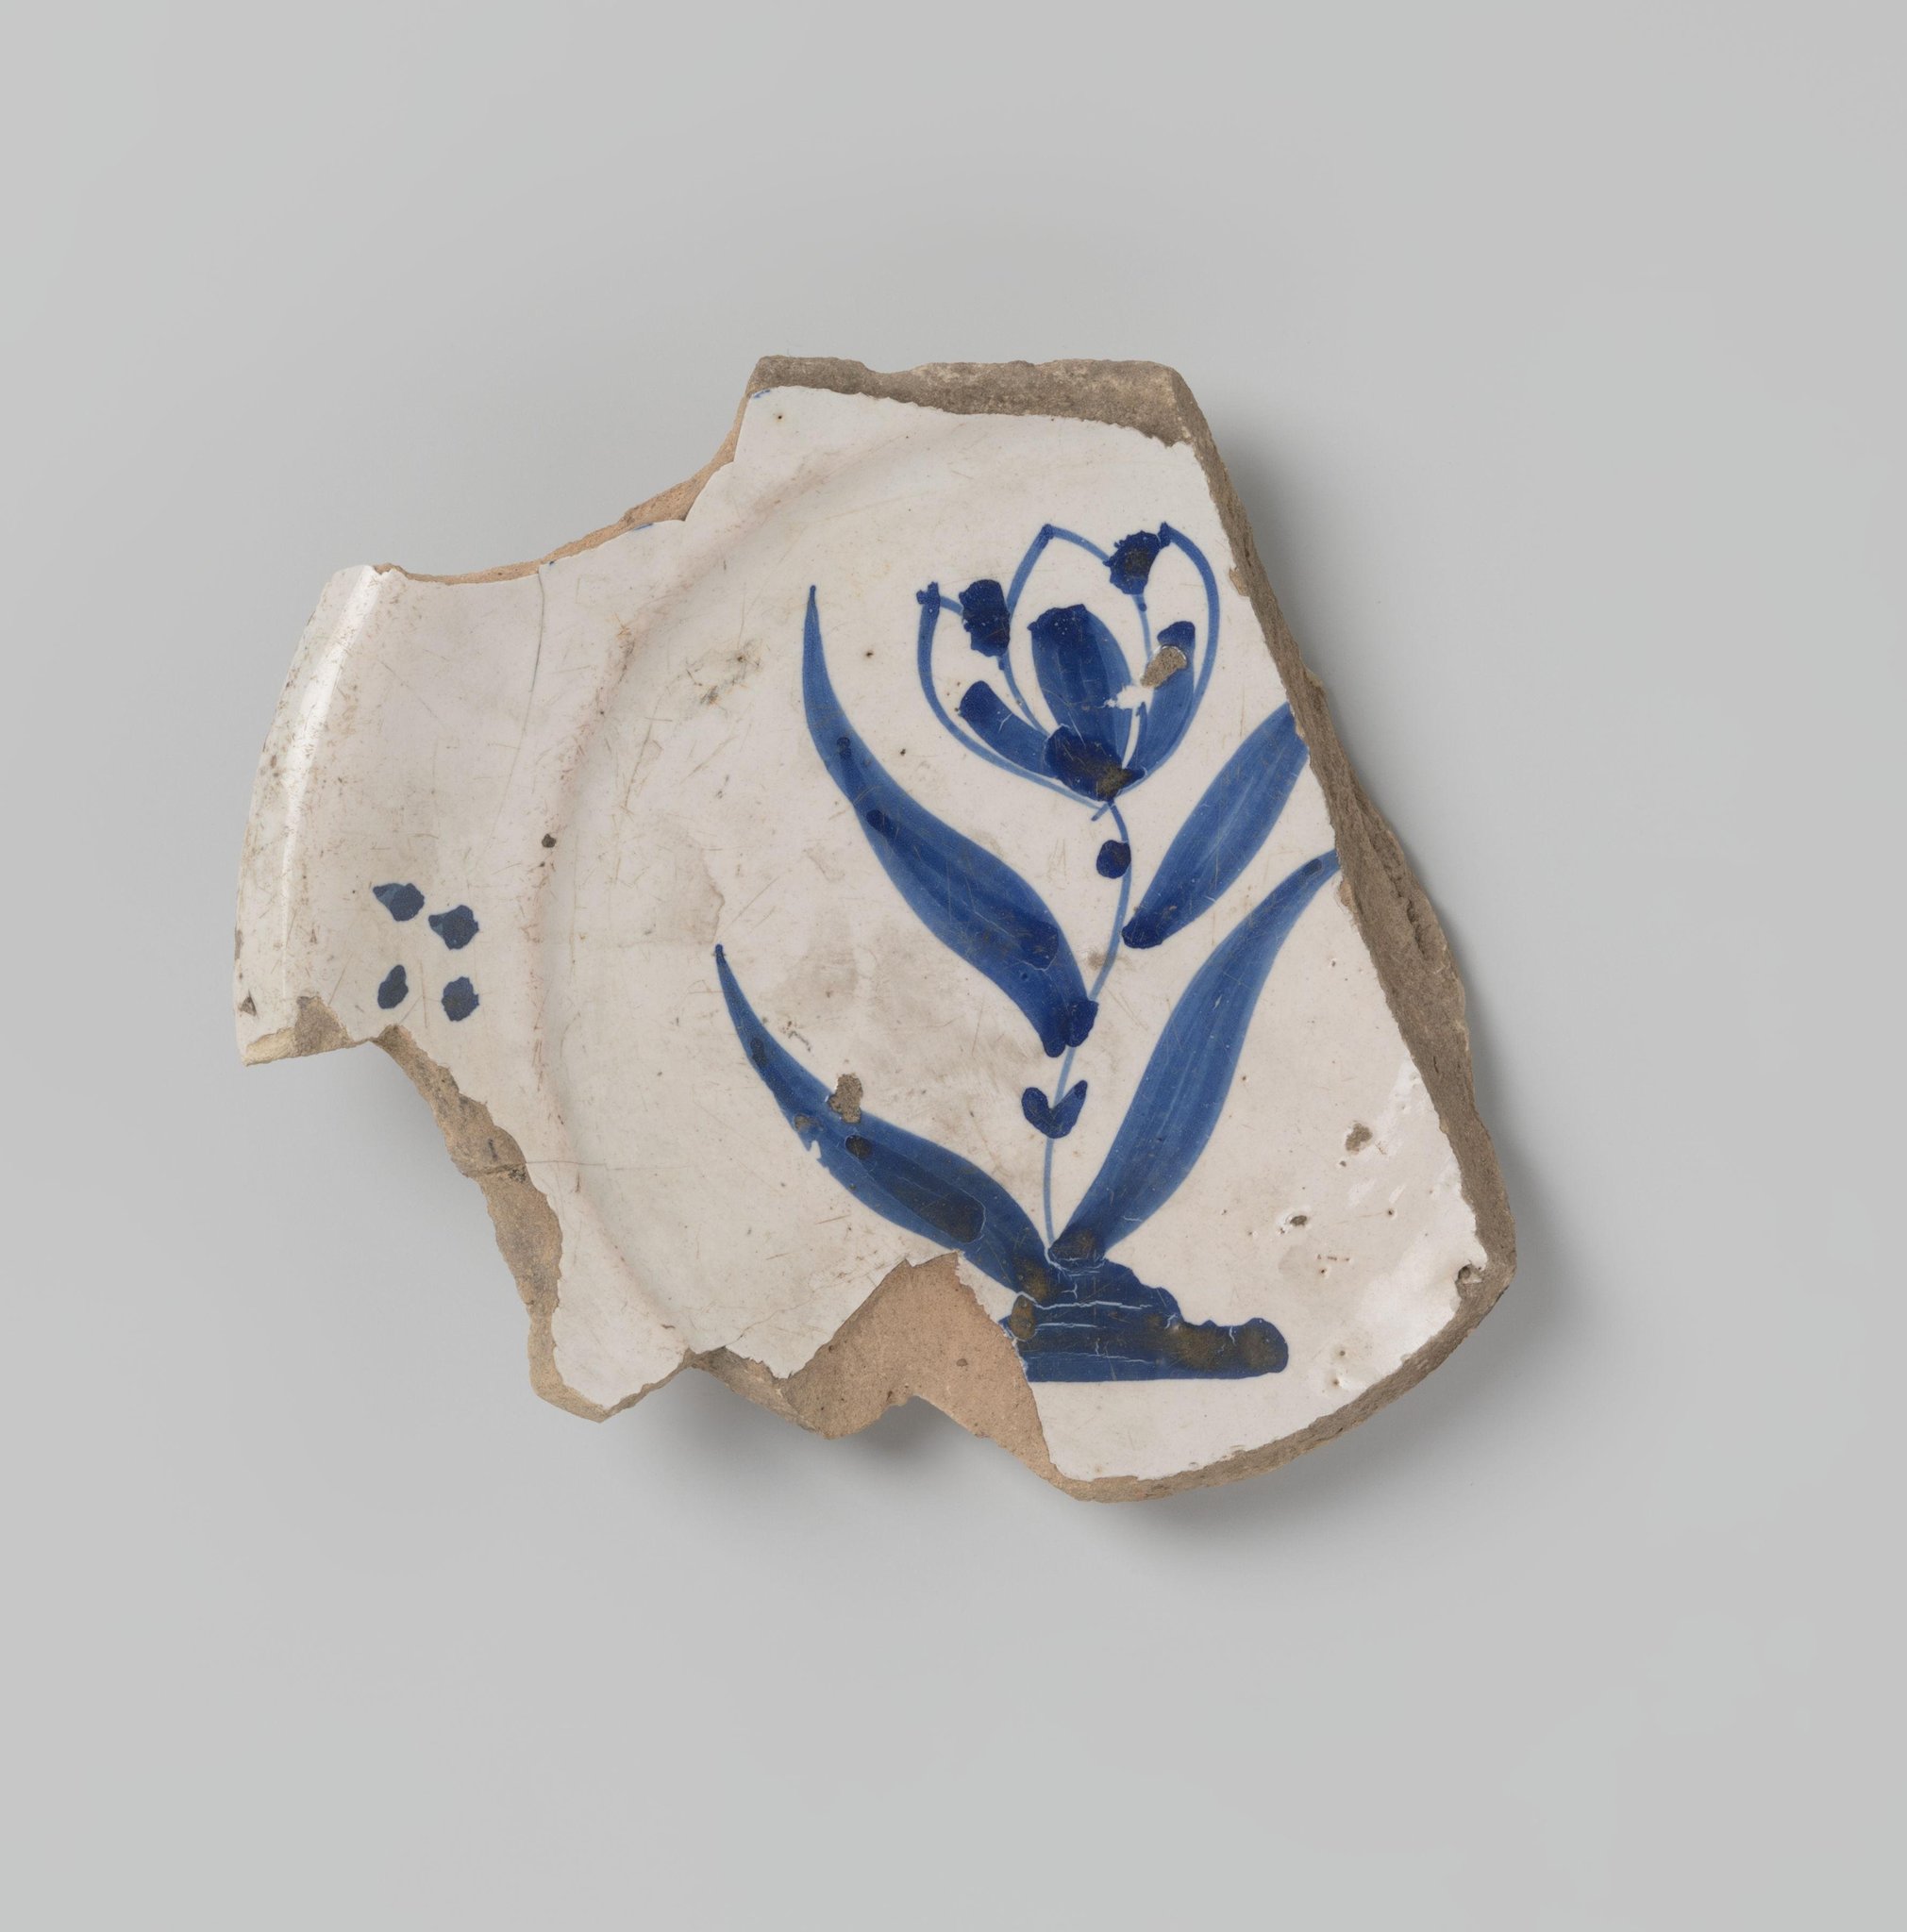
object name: sherd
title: Schotelscherf van aardewerk met tekening een tulp, in onderglazuur blauw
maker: Anonymous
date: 1500-1799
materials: earthenware, glaze